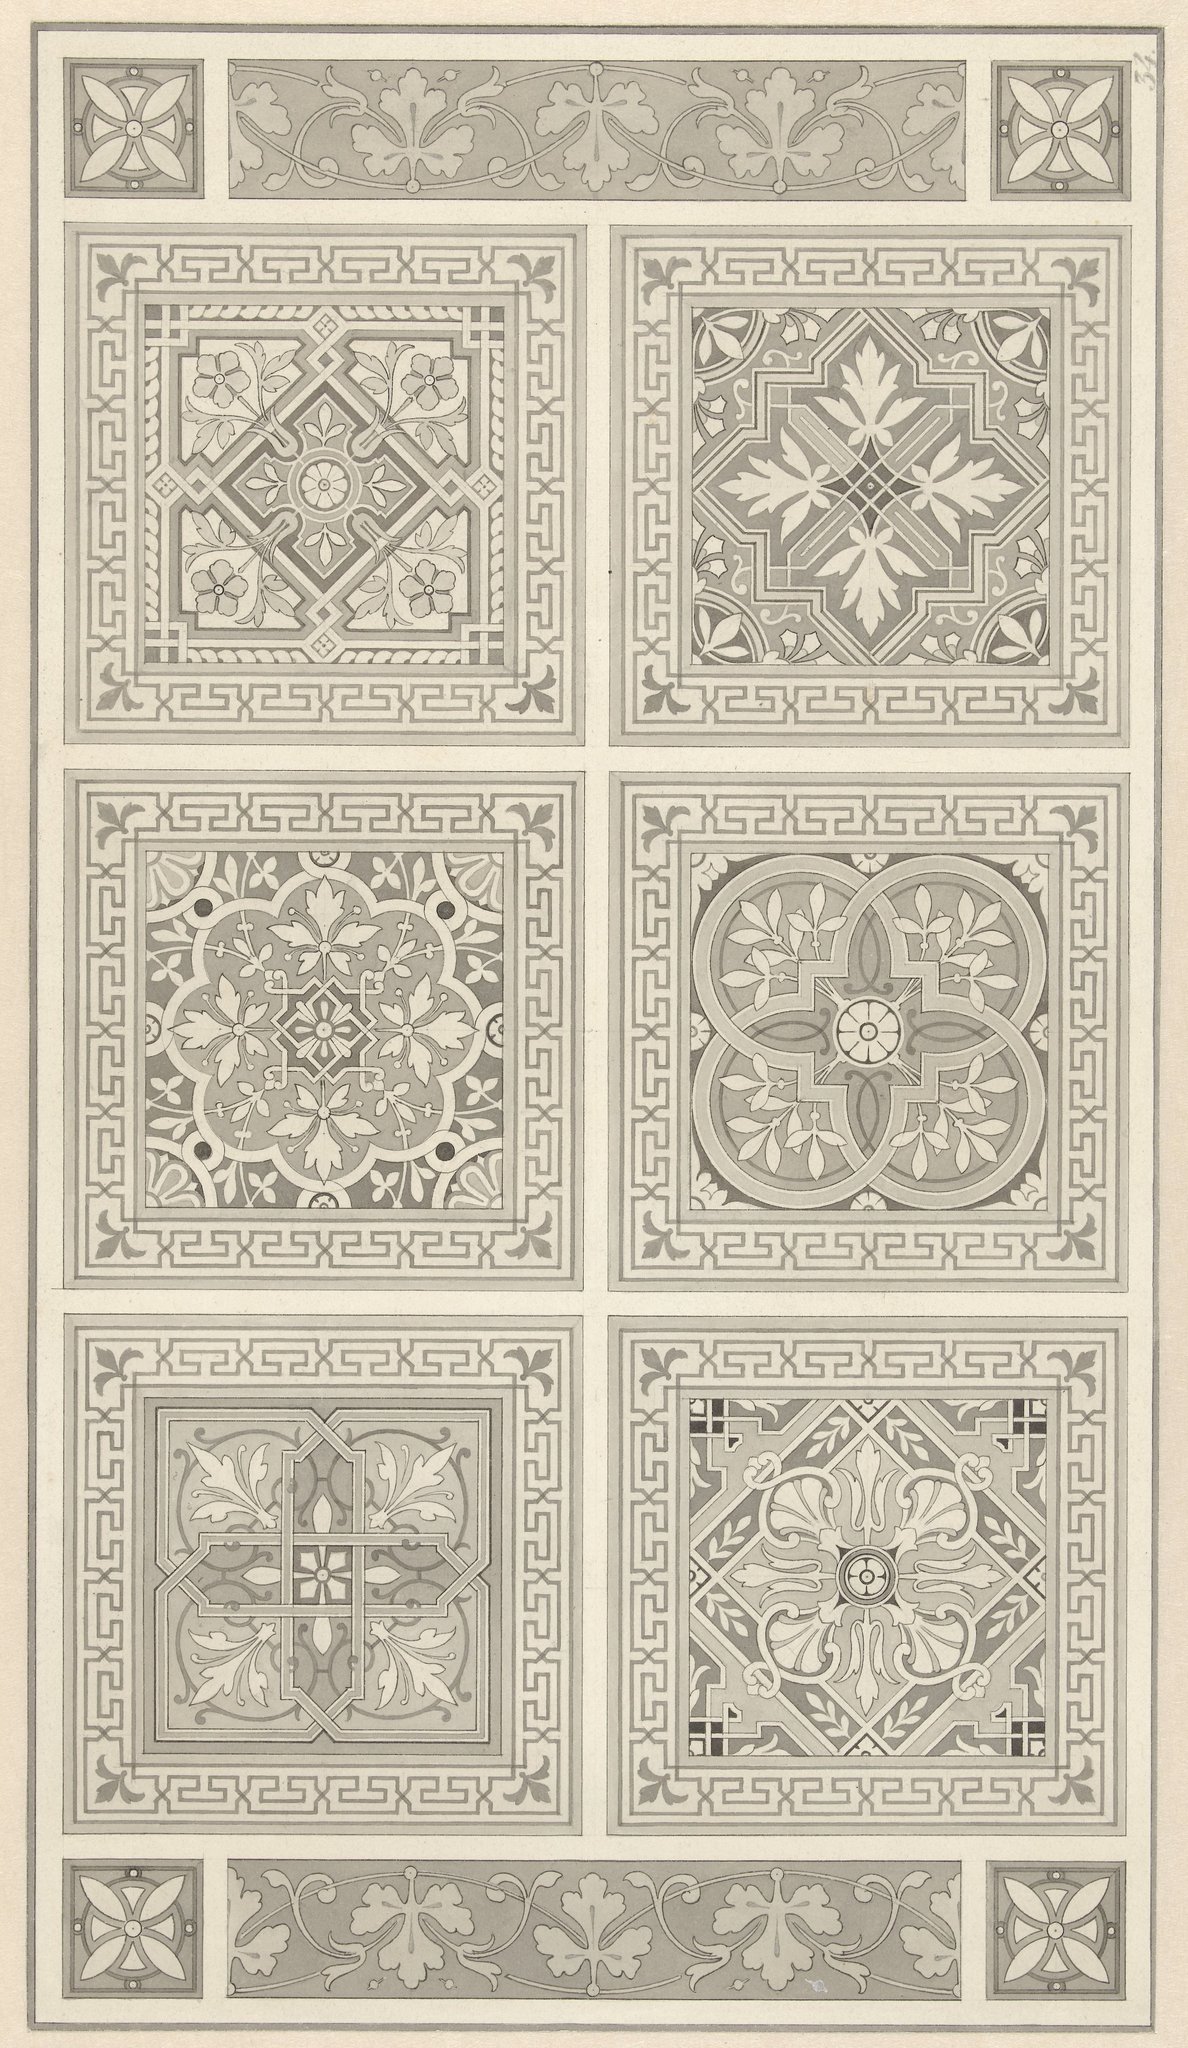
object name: drawing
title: Vlakvulling van friezen en vierkanten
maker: alexandre eugène prignot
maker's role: draughtsman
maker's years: 1822-1875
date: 1832-1875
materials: ink, paper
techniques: brush, pen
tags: wall-covering